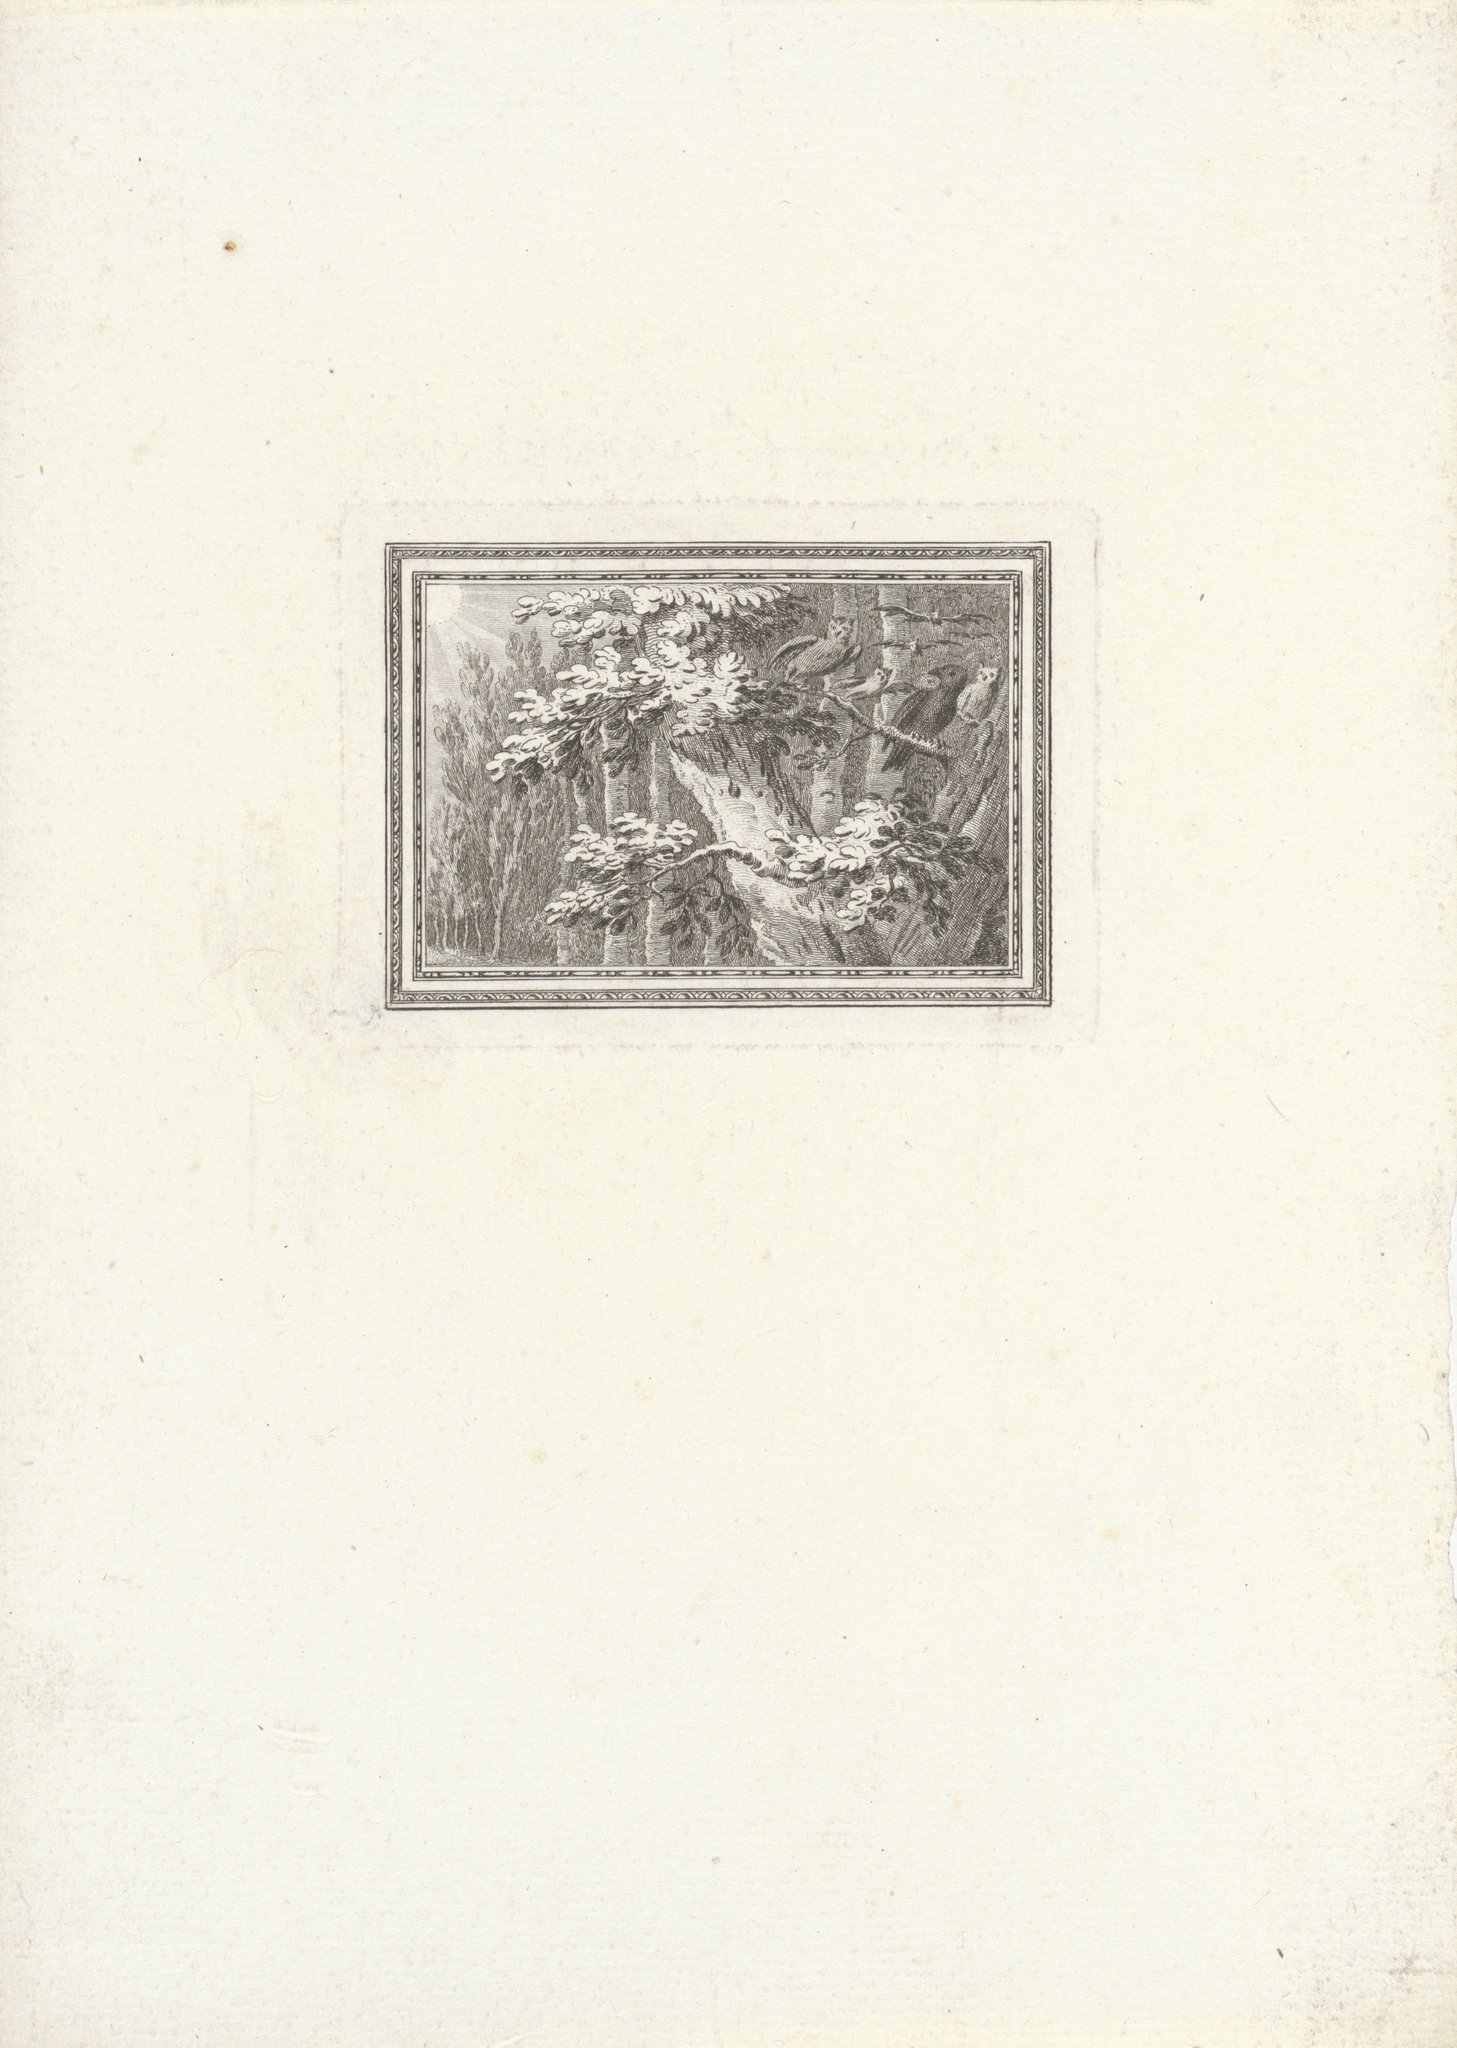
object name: book illustration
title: Nachtvogels in een boom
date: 1792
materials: paper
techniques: etching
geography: amsterdam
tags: flying mammals: bat, birds, owls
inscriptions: collector's mark: Lugt 2228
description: Terwijl de zon straalt zitten verschillende nachtvogels op stok in de schaduw van het geboomte. Illustratie bij het verhaal 'De zon en de nachtvogels' uit 'Fabelen voor de Nederlandsche jeugd'.